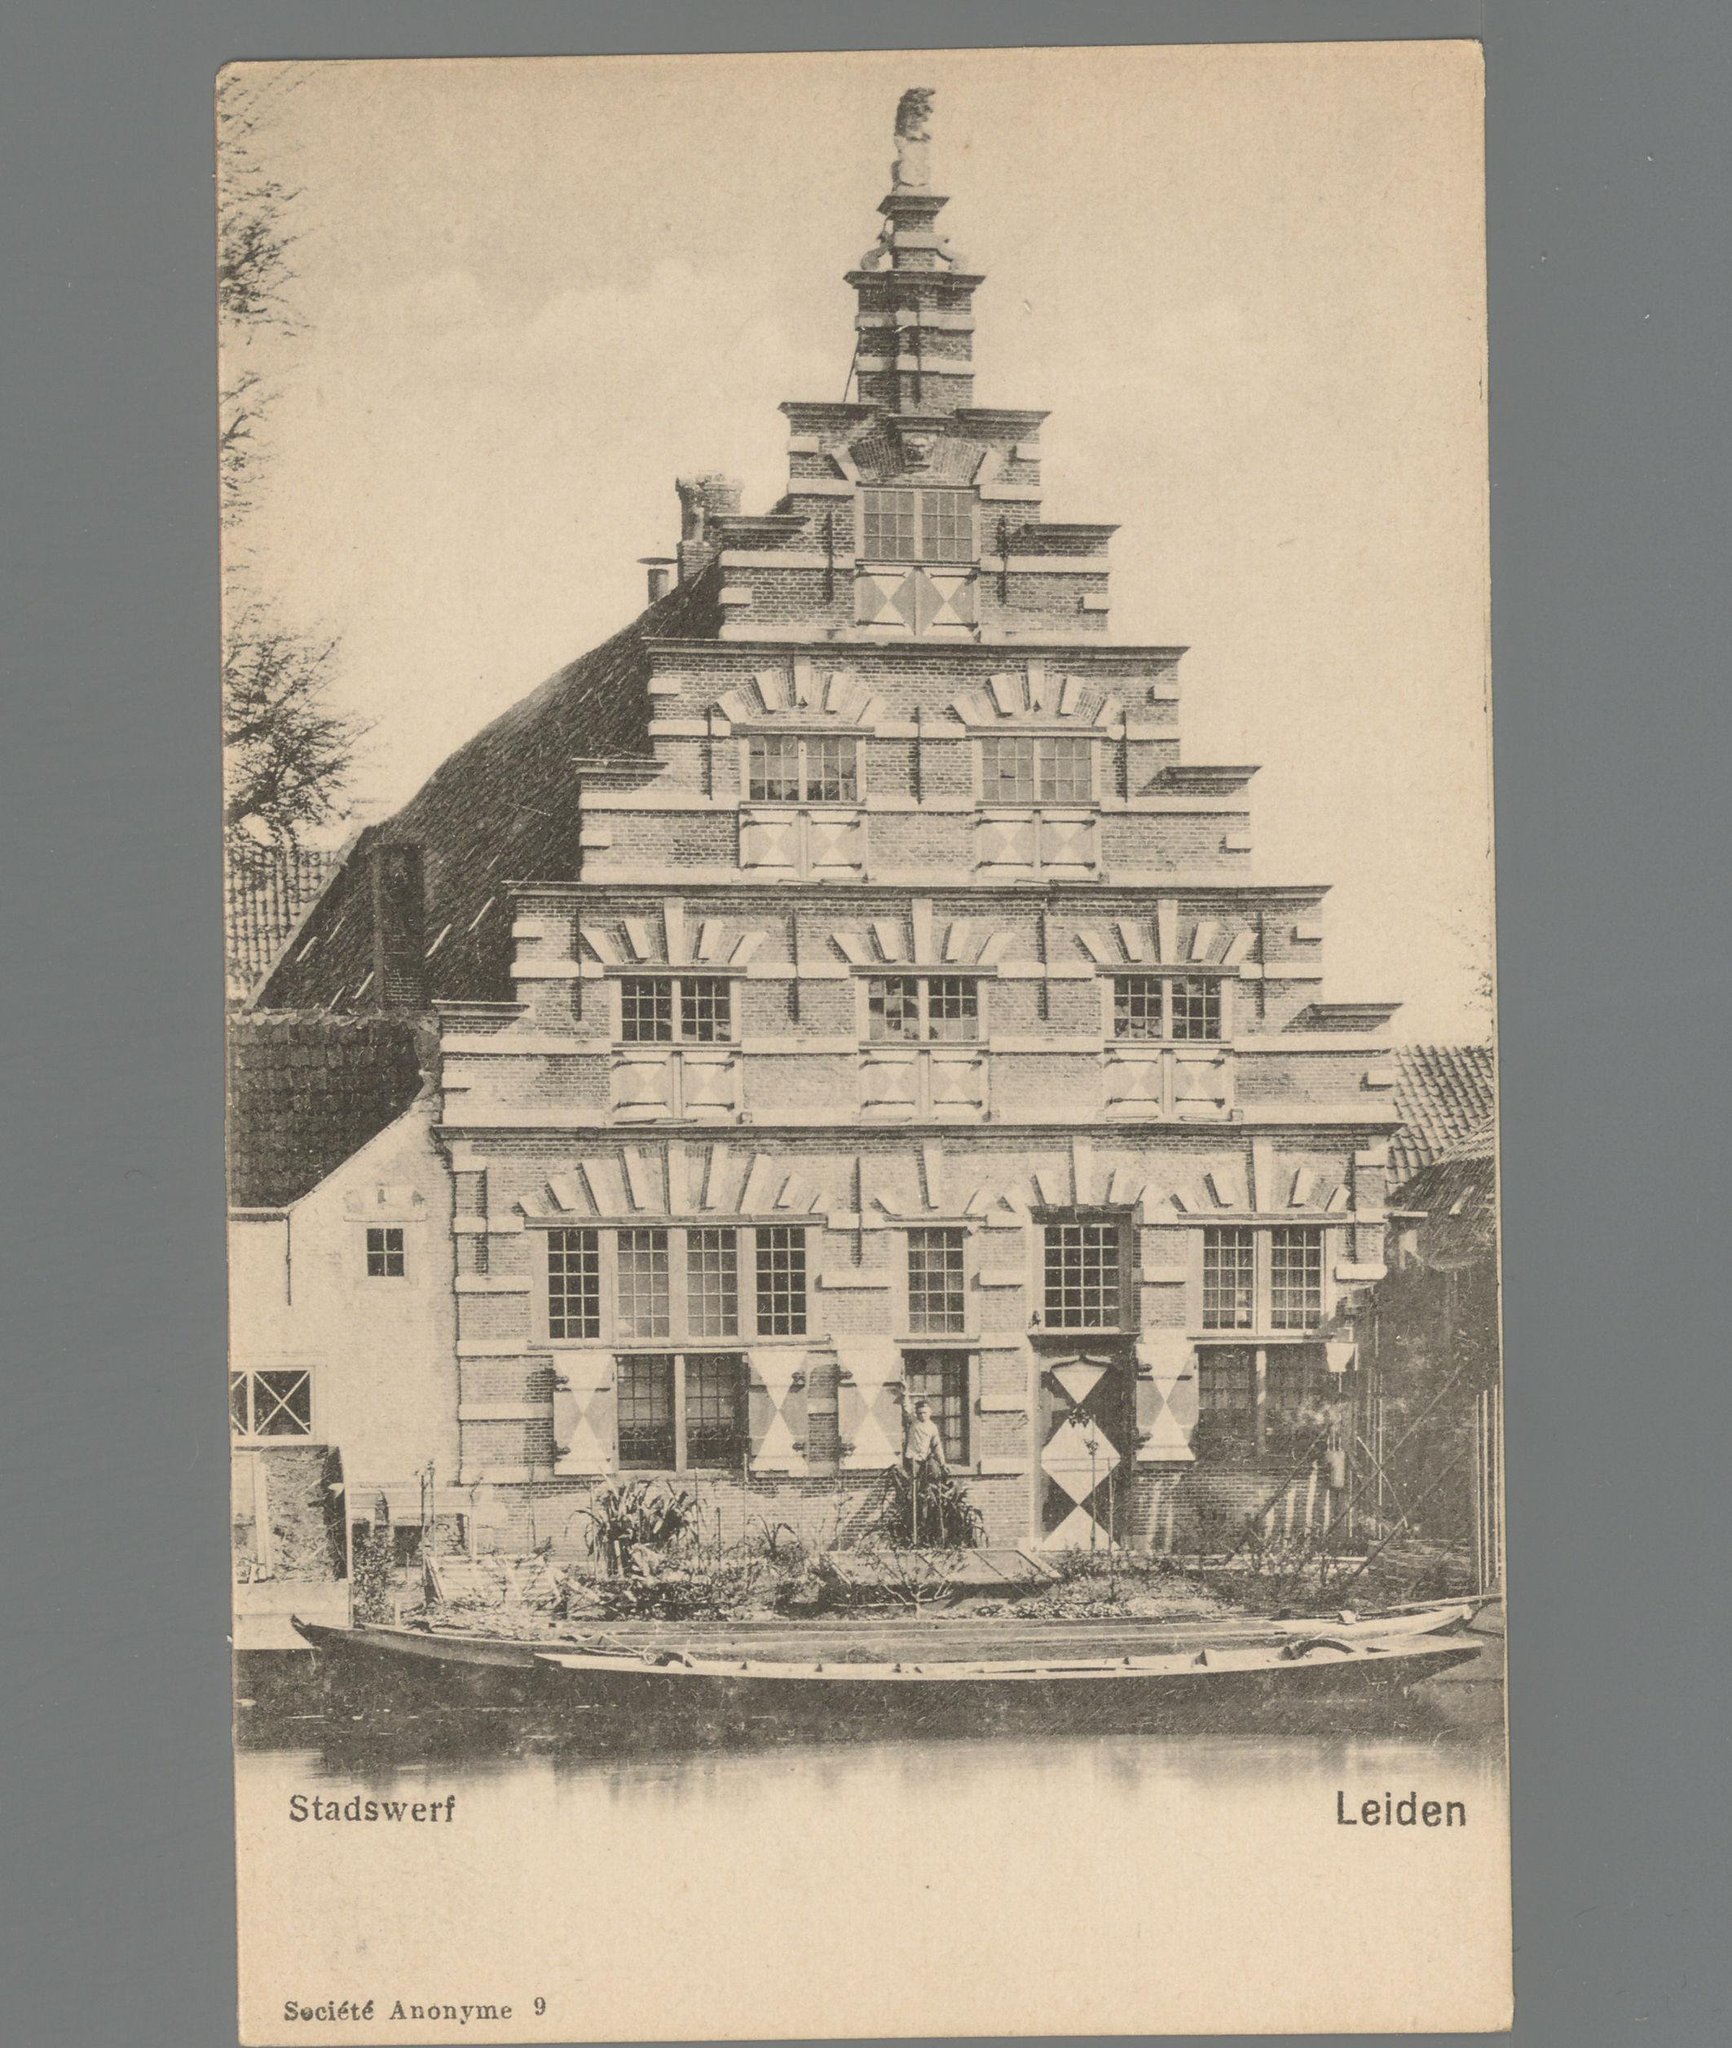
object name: photomechanical print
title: Stadswerf. Leiden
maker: Anonymous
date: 1897-1905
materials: cardboard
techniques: photograph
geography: leiden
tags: carpenter, workshop